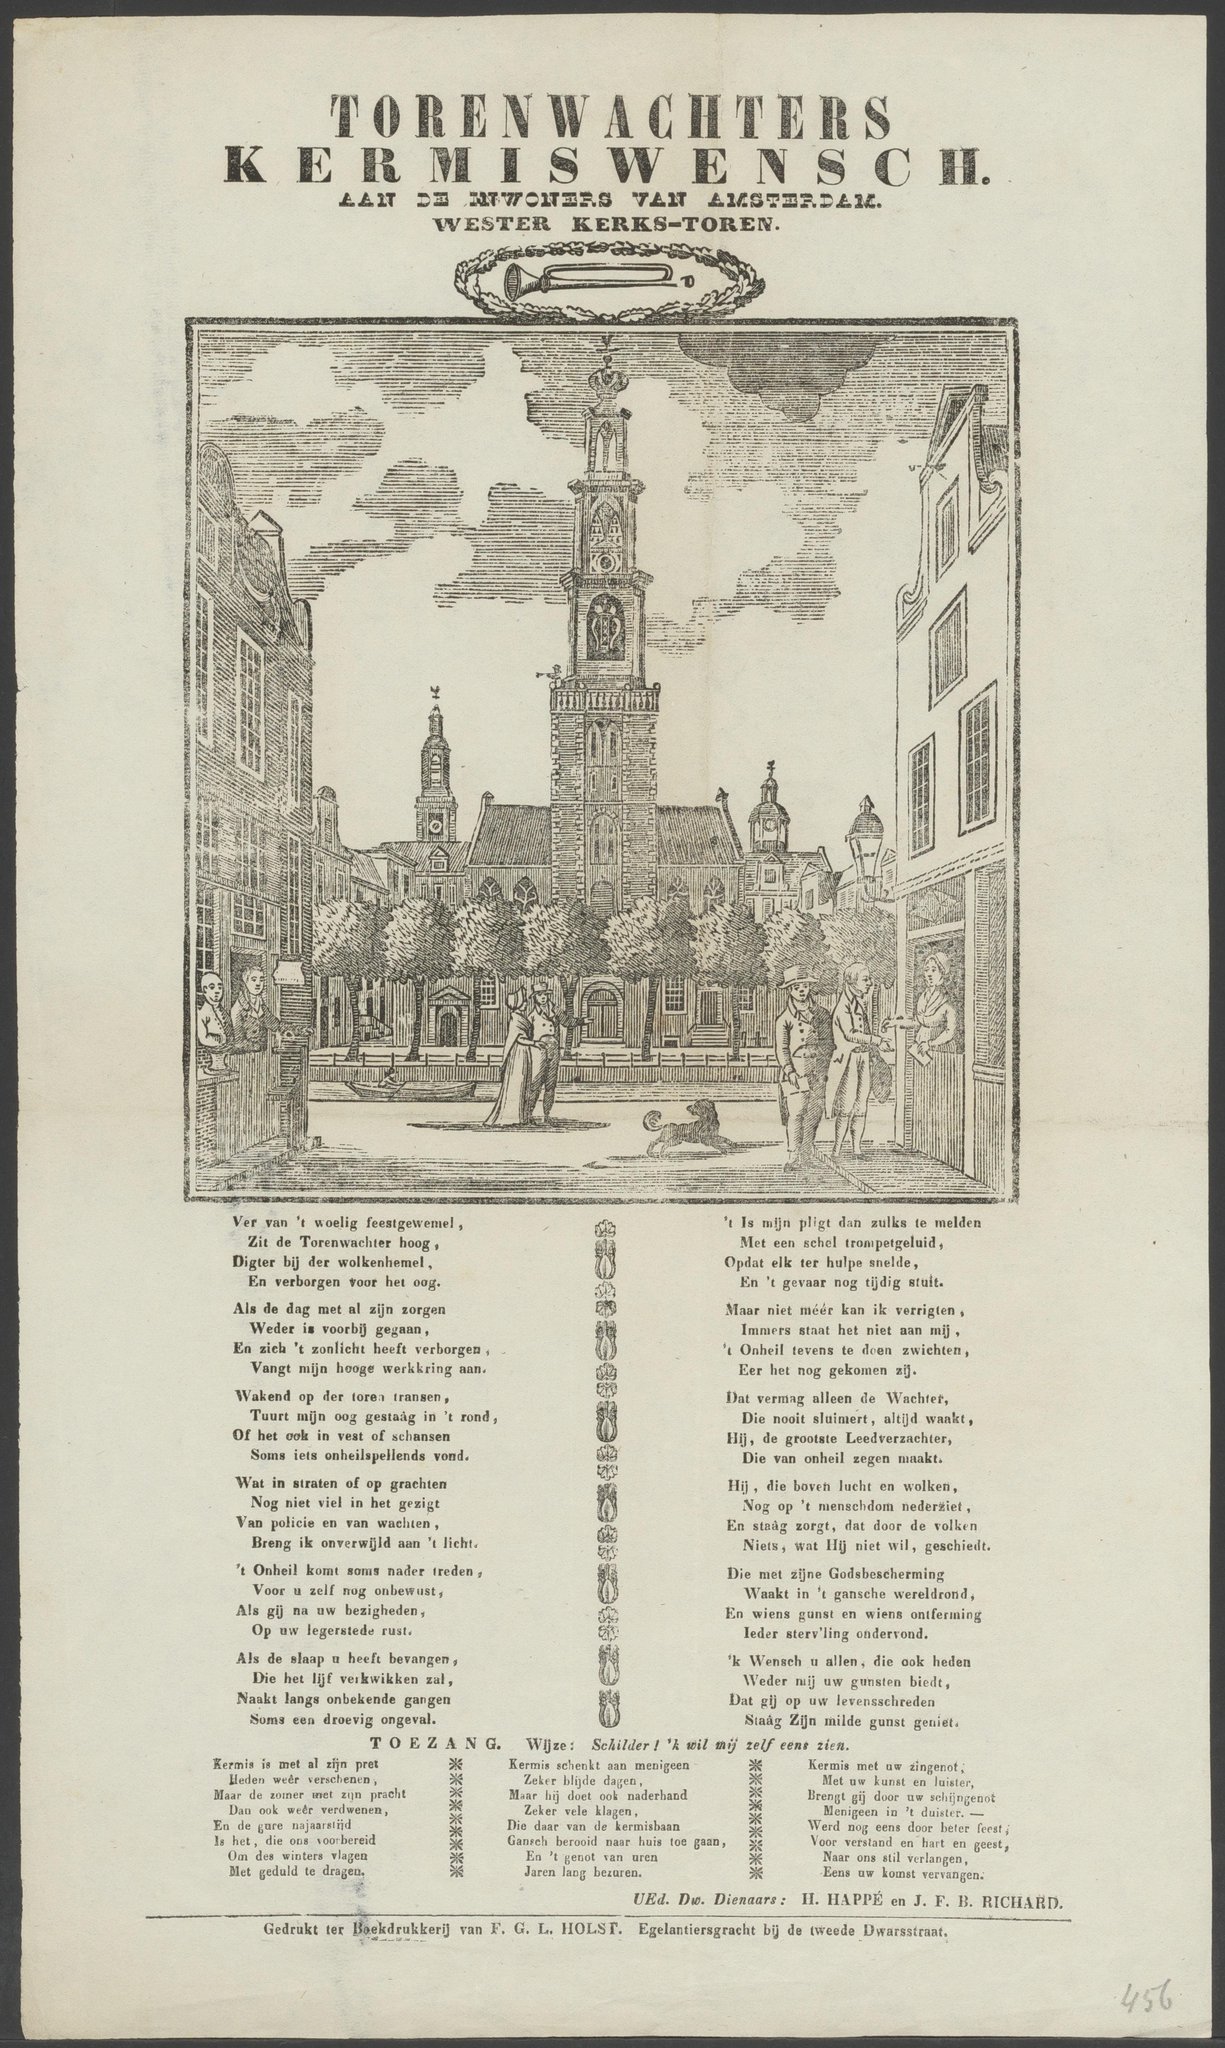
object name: print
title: Torenwachters kermiswensch. aan de inwoners van Amsterdam. Wester Kerks-toren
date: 1841-1864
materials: paper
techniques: letterpress printing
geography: amsterdam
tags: parts of church exterior and annexes: tower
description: Nieuwjaarswens van de torenwachters van de Westerkerkstoren te Amsterdam. Bovenaan een gezicht op een kerktoren. Daaronder centraal een gedicht in twee kolommen. Onderaan een toezang in drie kolommen. Aangeboden door de torenwachters: H. Happé en J.F.B. Richard. Onderwerpsrubrieken binnen de Atlas Zeden en Gewoonten: Zeden en gewoonten in engeren zin, Volksleven, Volksbladen, Nieuwjaars- en Kerstwenschen, Amsterdam.